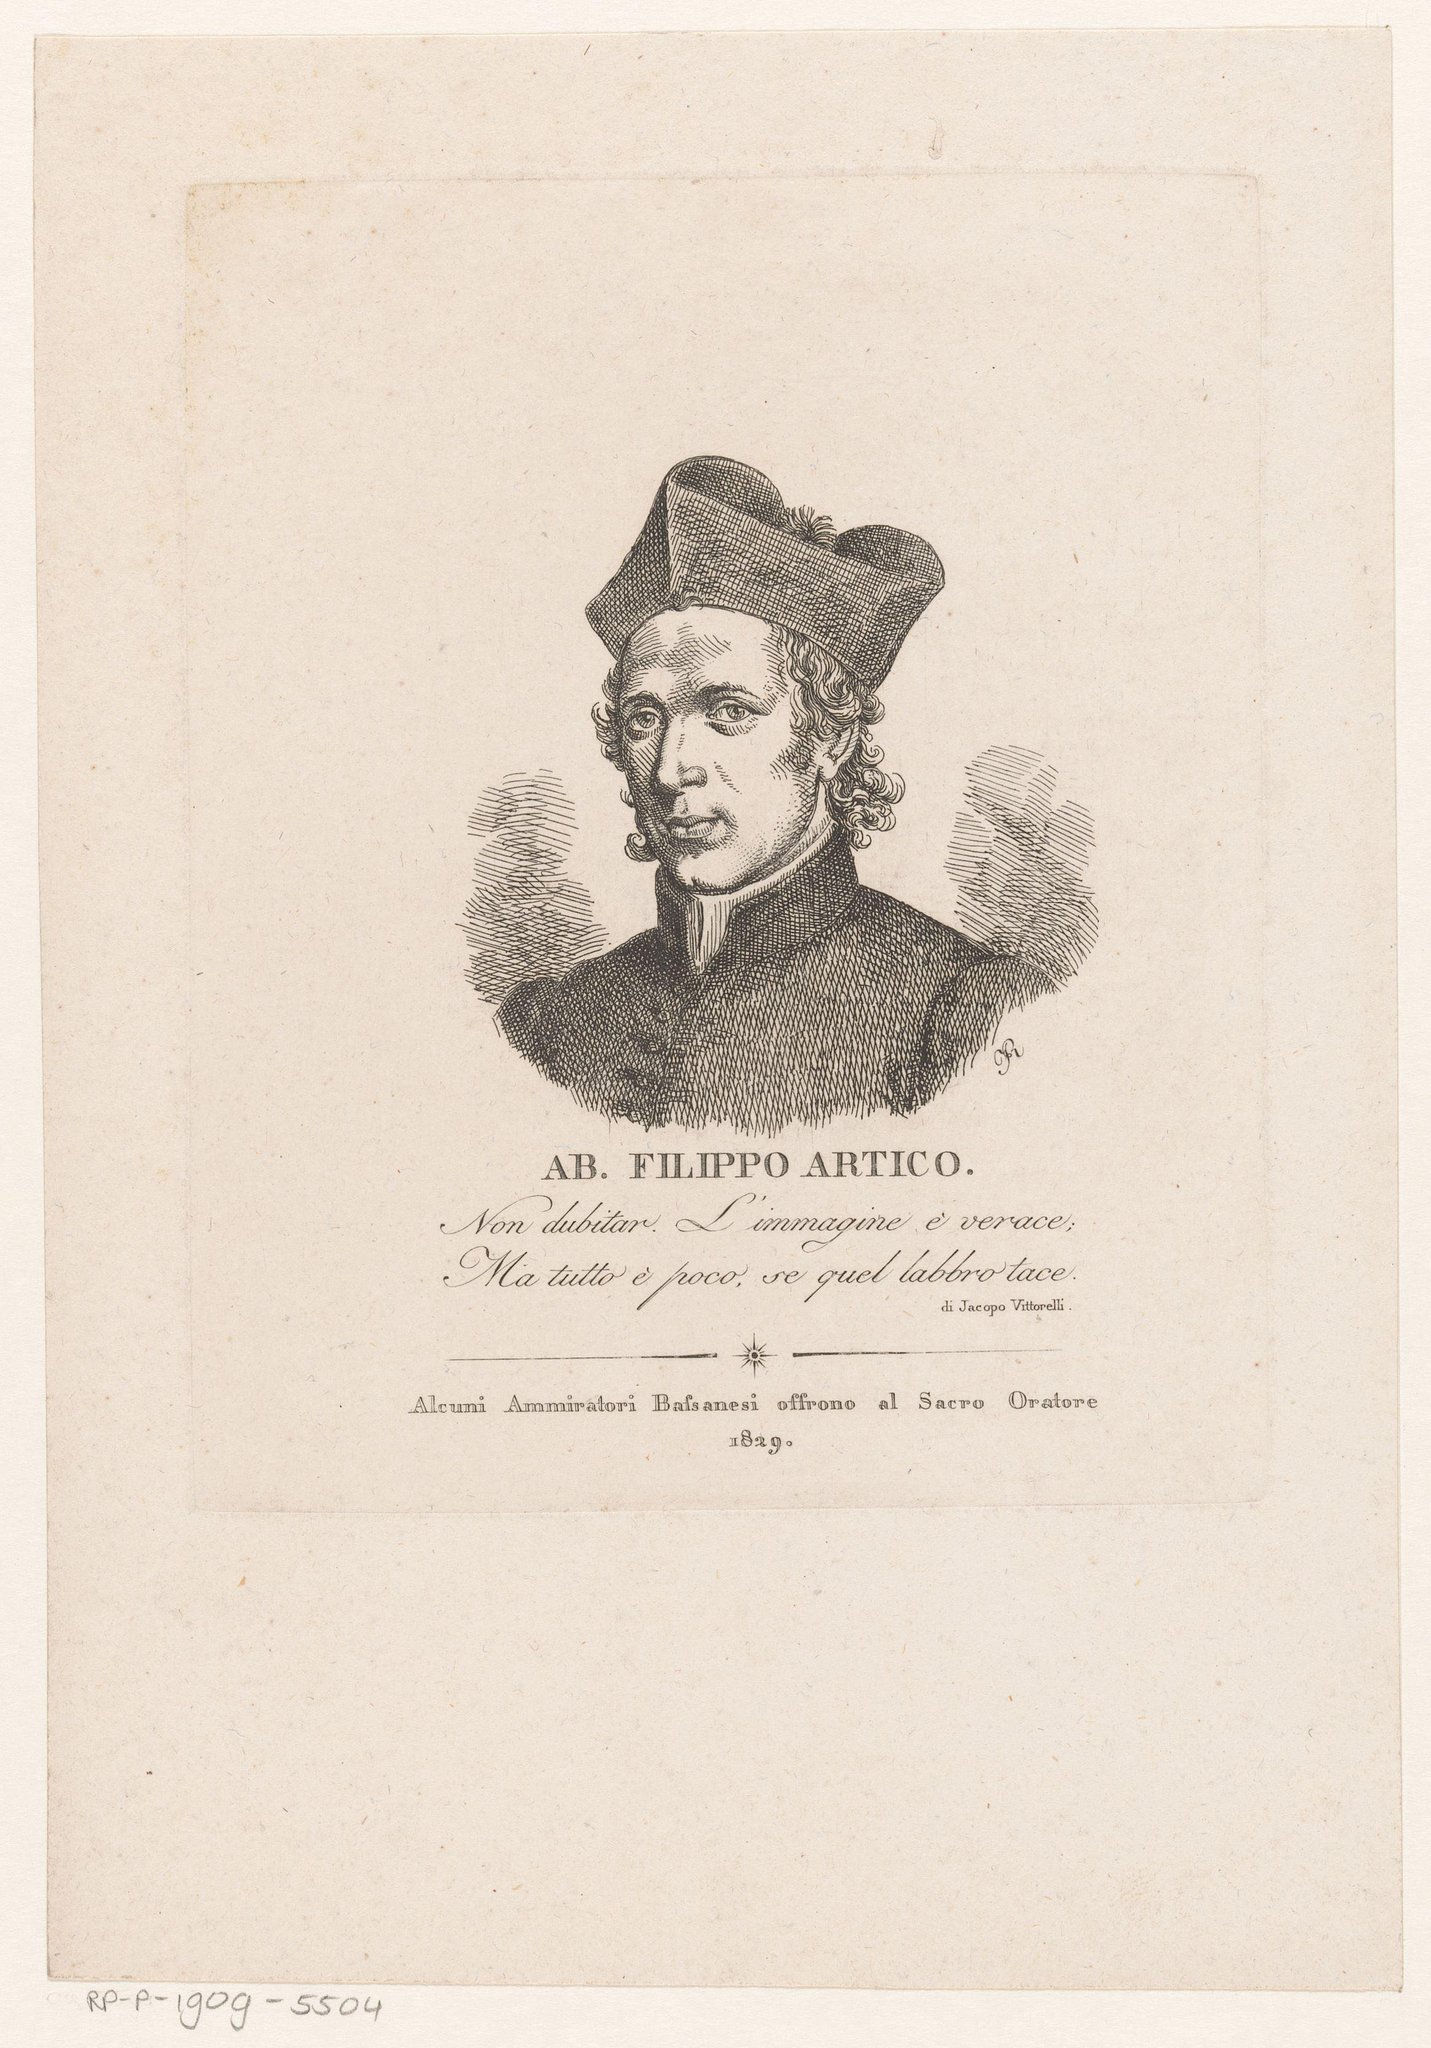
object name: print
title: Portret van geestelijke Filippo Artico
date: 1829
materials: paper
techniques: etching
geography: italy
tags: rome, clergyman, historical persons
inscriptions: collector's mark: Lugt 2228